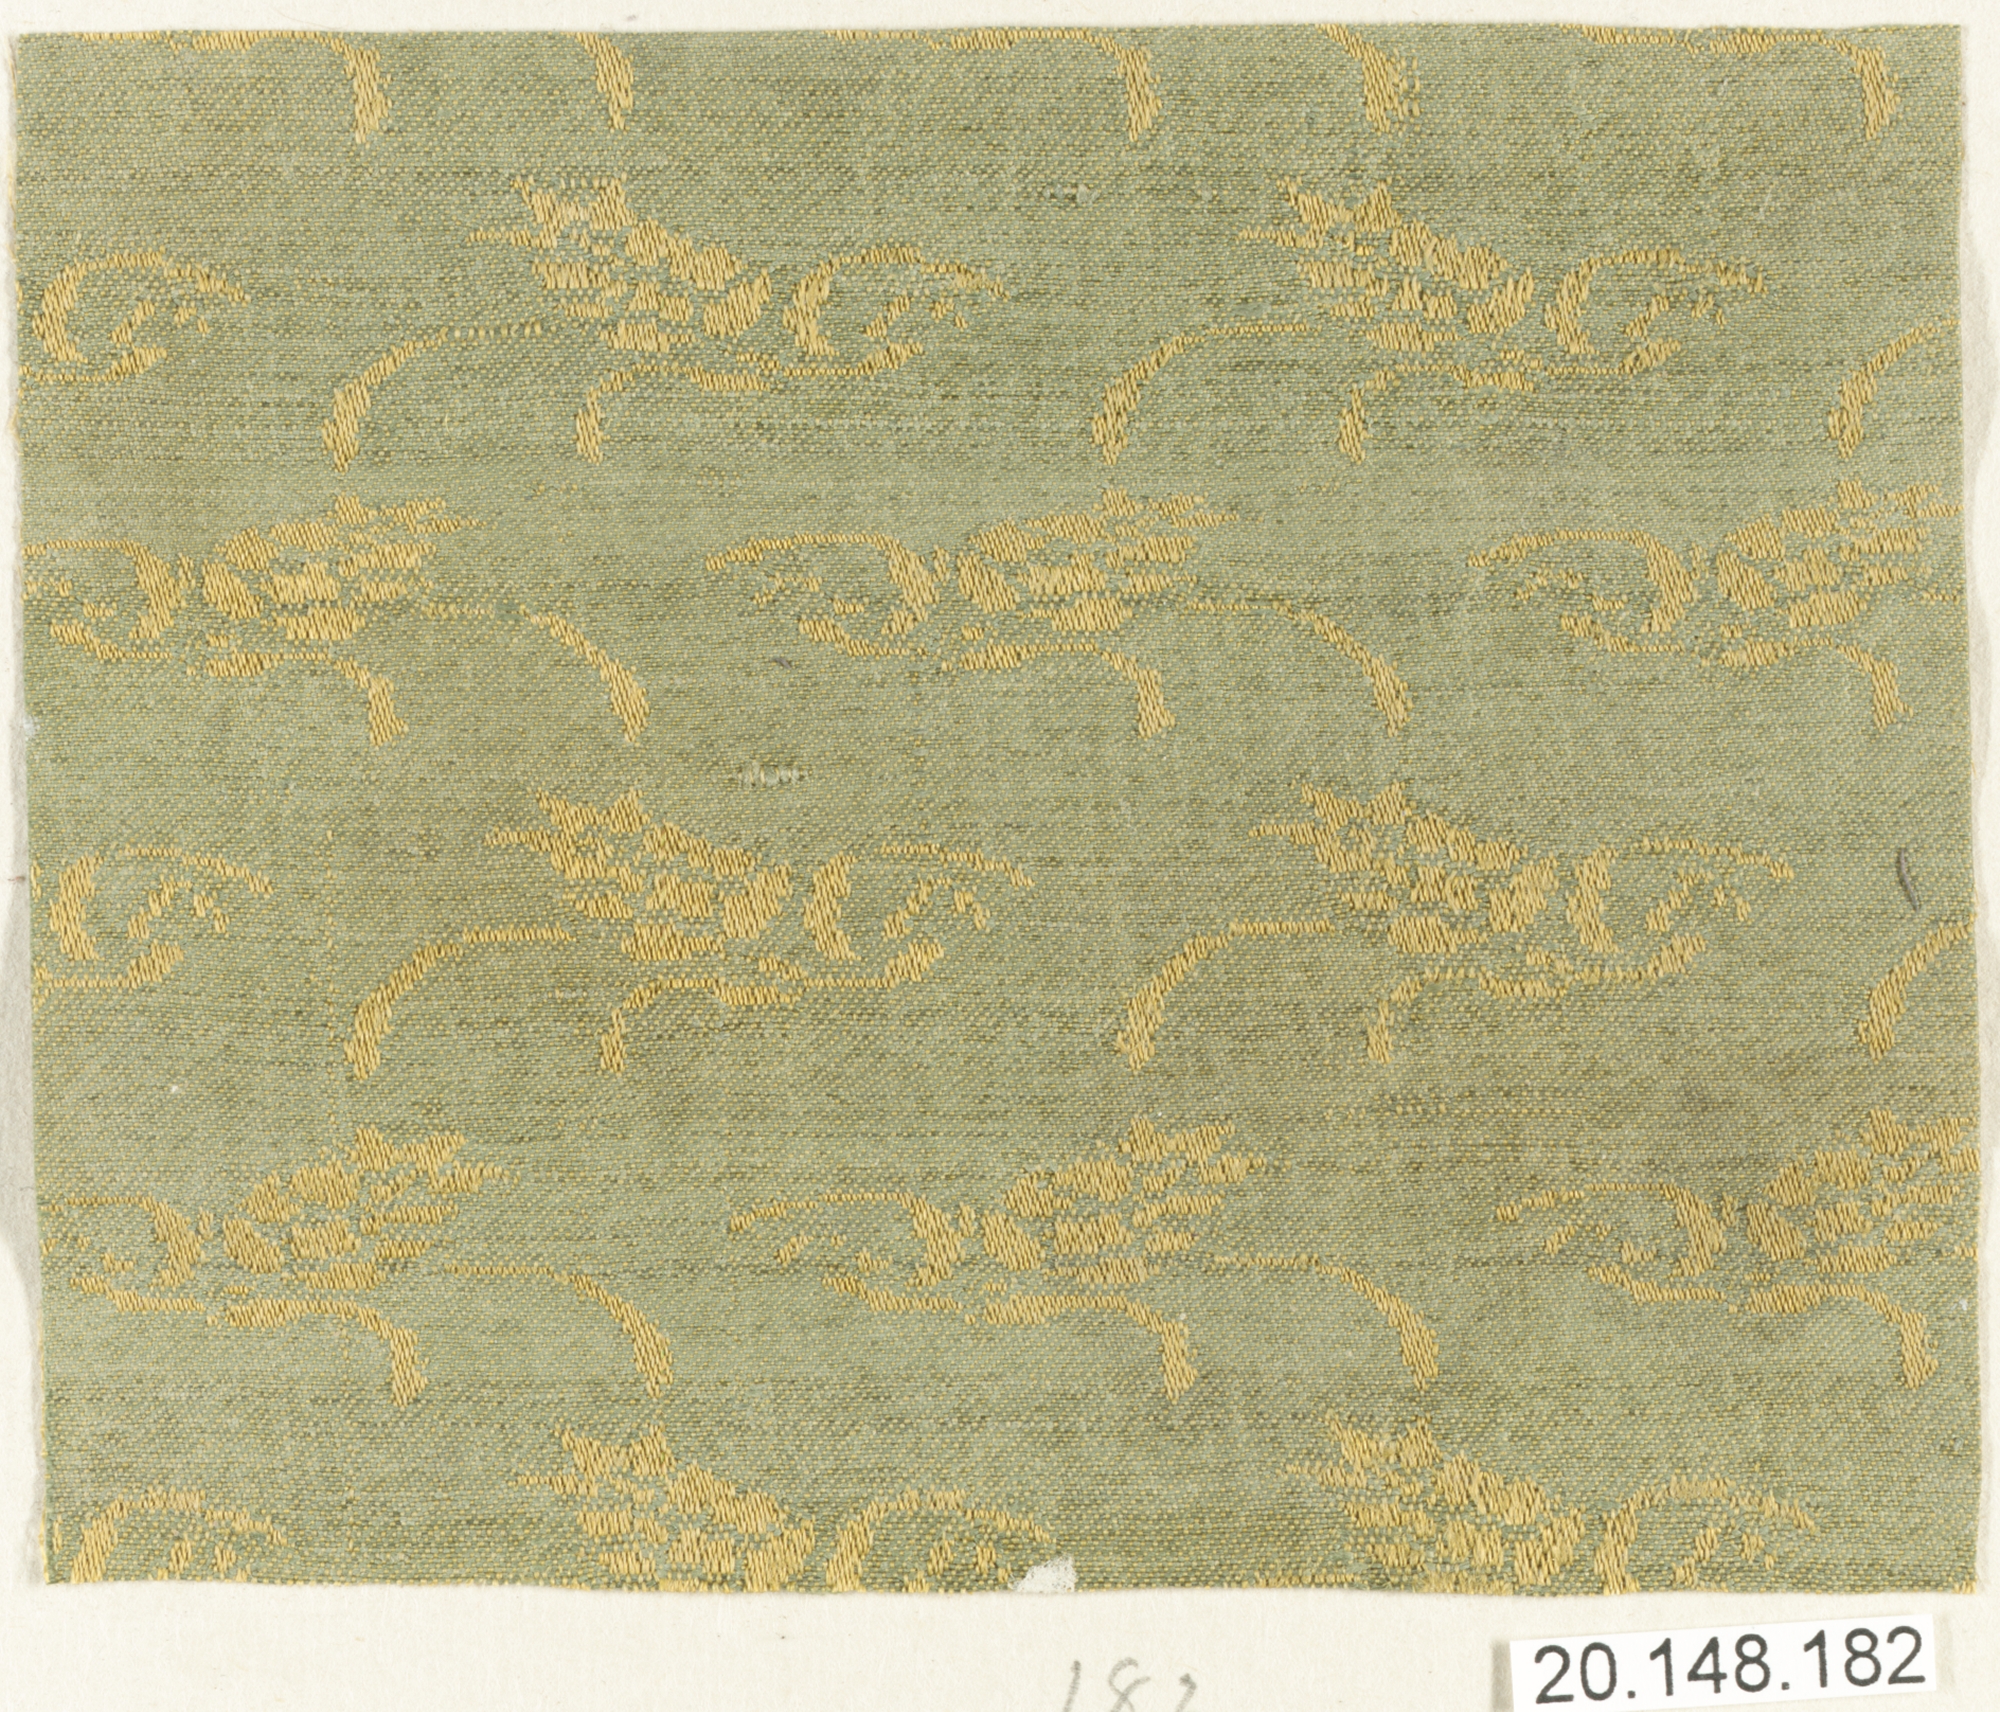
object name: piece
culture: japanese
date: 1701-1800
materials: silk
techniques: compound weave